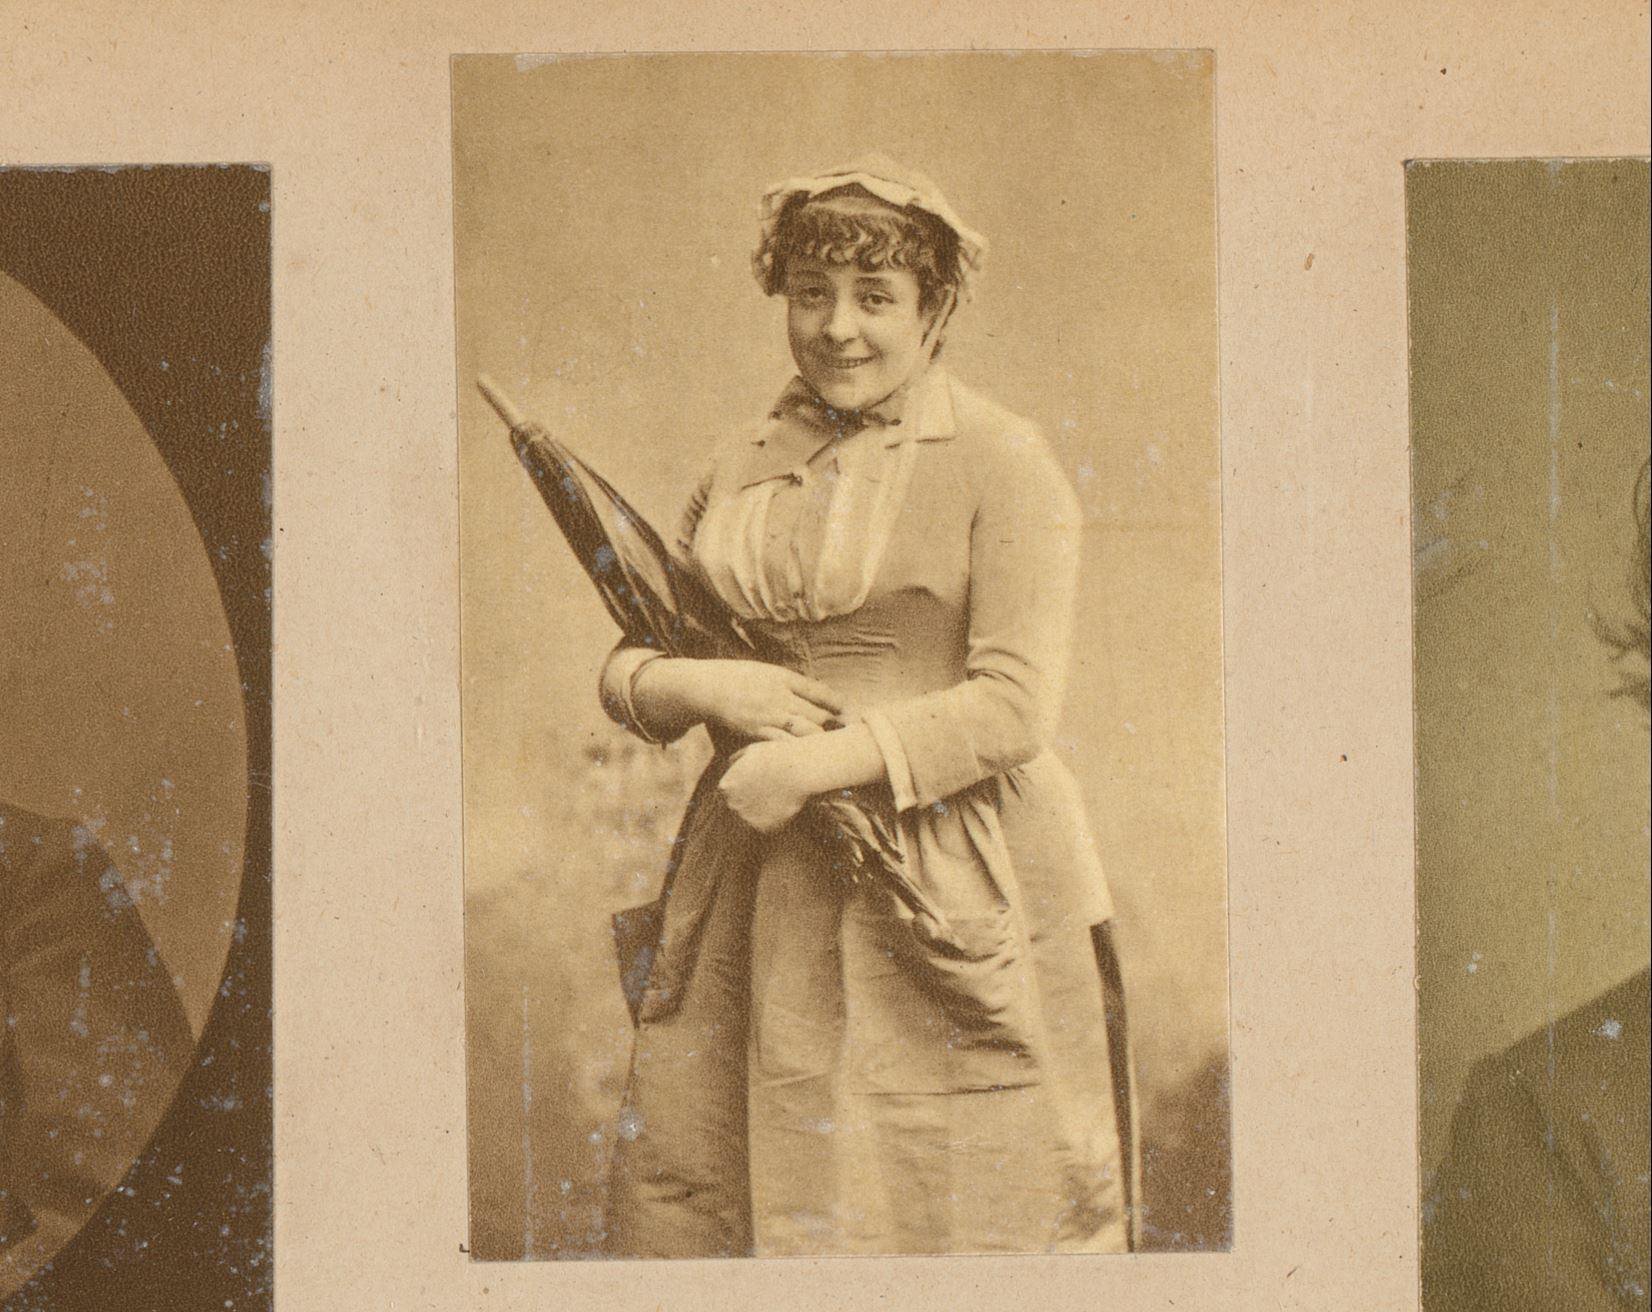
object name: album leaf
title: Portret van Anna Judic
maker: Anonymous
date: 1875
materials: paper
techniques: rotogravure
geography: france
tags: portrait of actor, actress, france